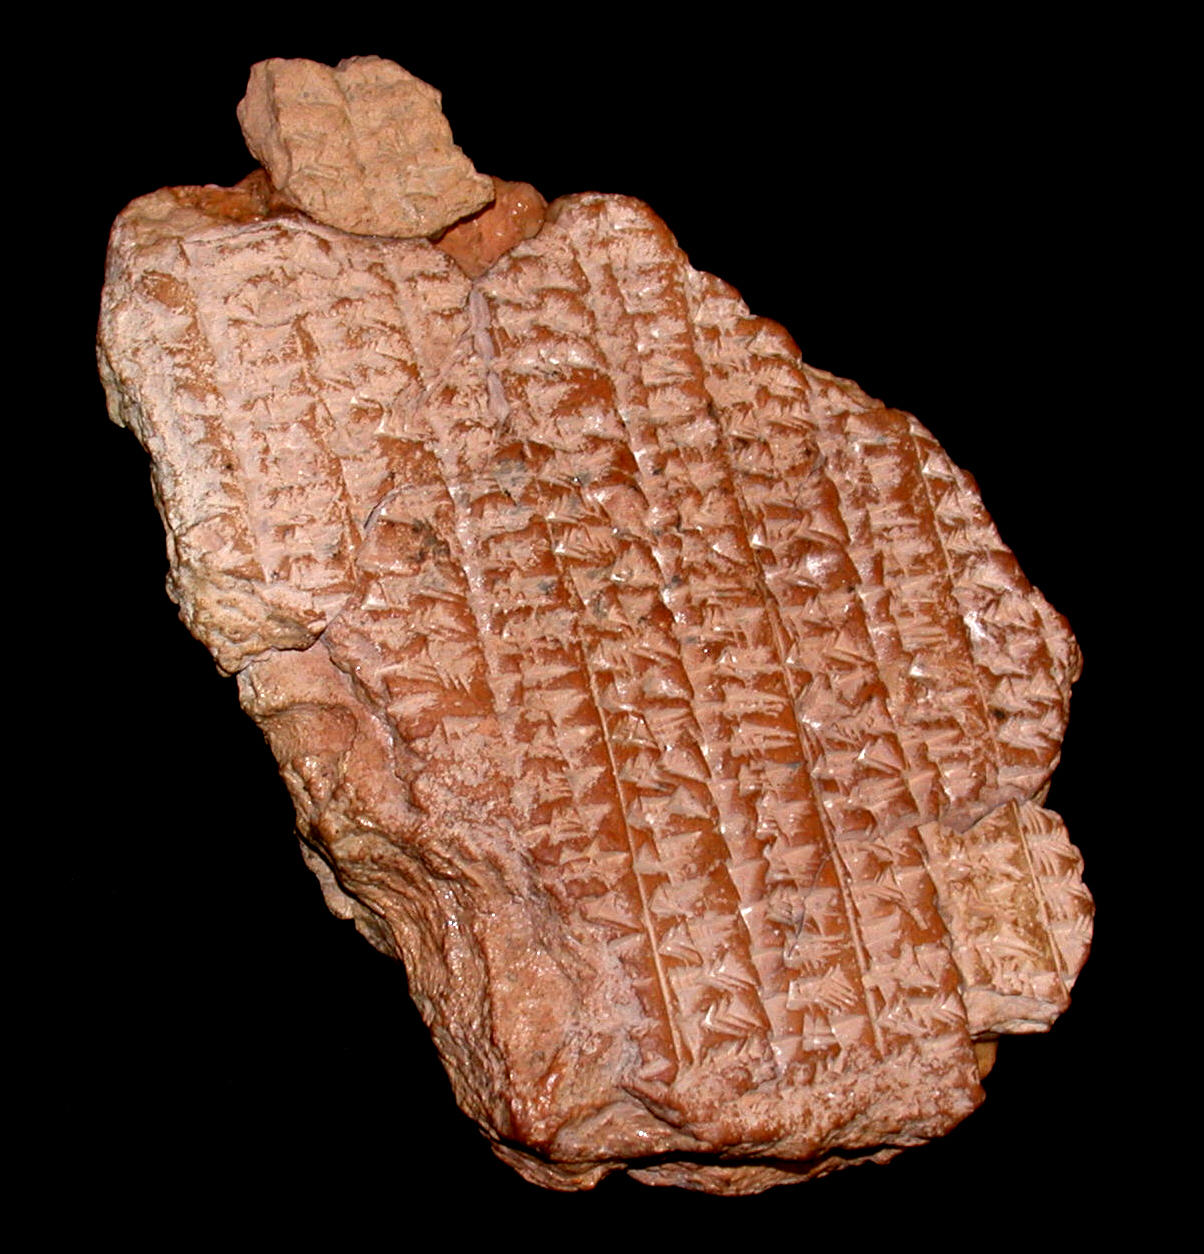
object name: cuneiform tablet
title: Cuneiform tablet: number-syllabary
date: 333-1 BCE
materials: clay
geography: mesopotamia